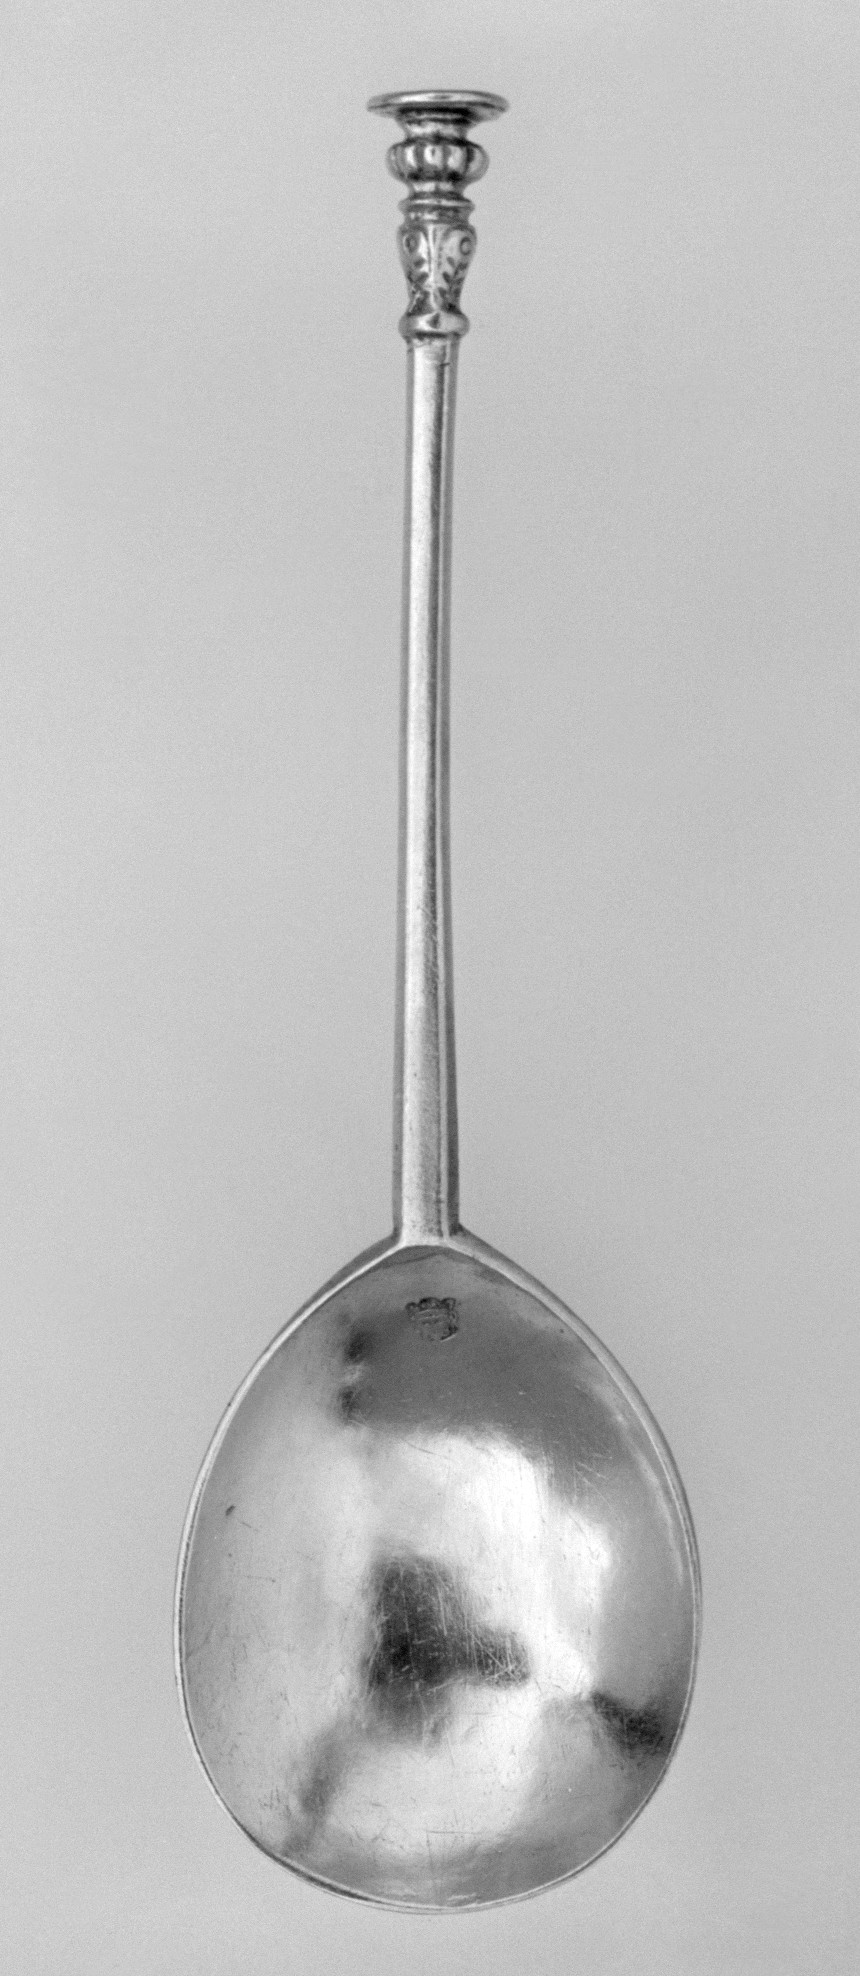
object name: spoon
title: Seal-top spoon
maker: i. f., london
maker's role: maker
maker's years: 1616-1624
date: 1623-1624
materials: silver gilt